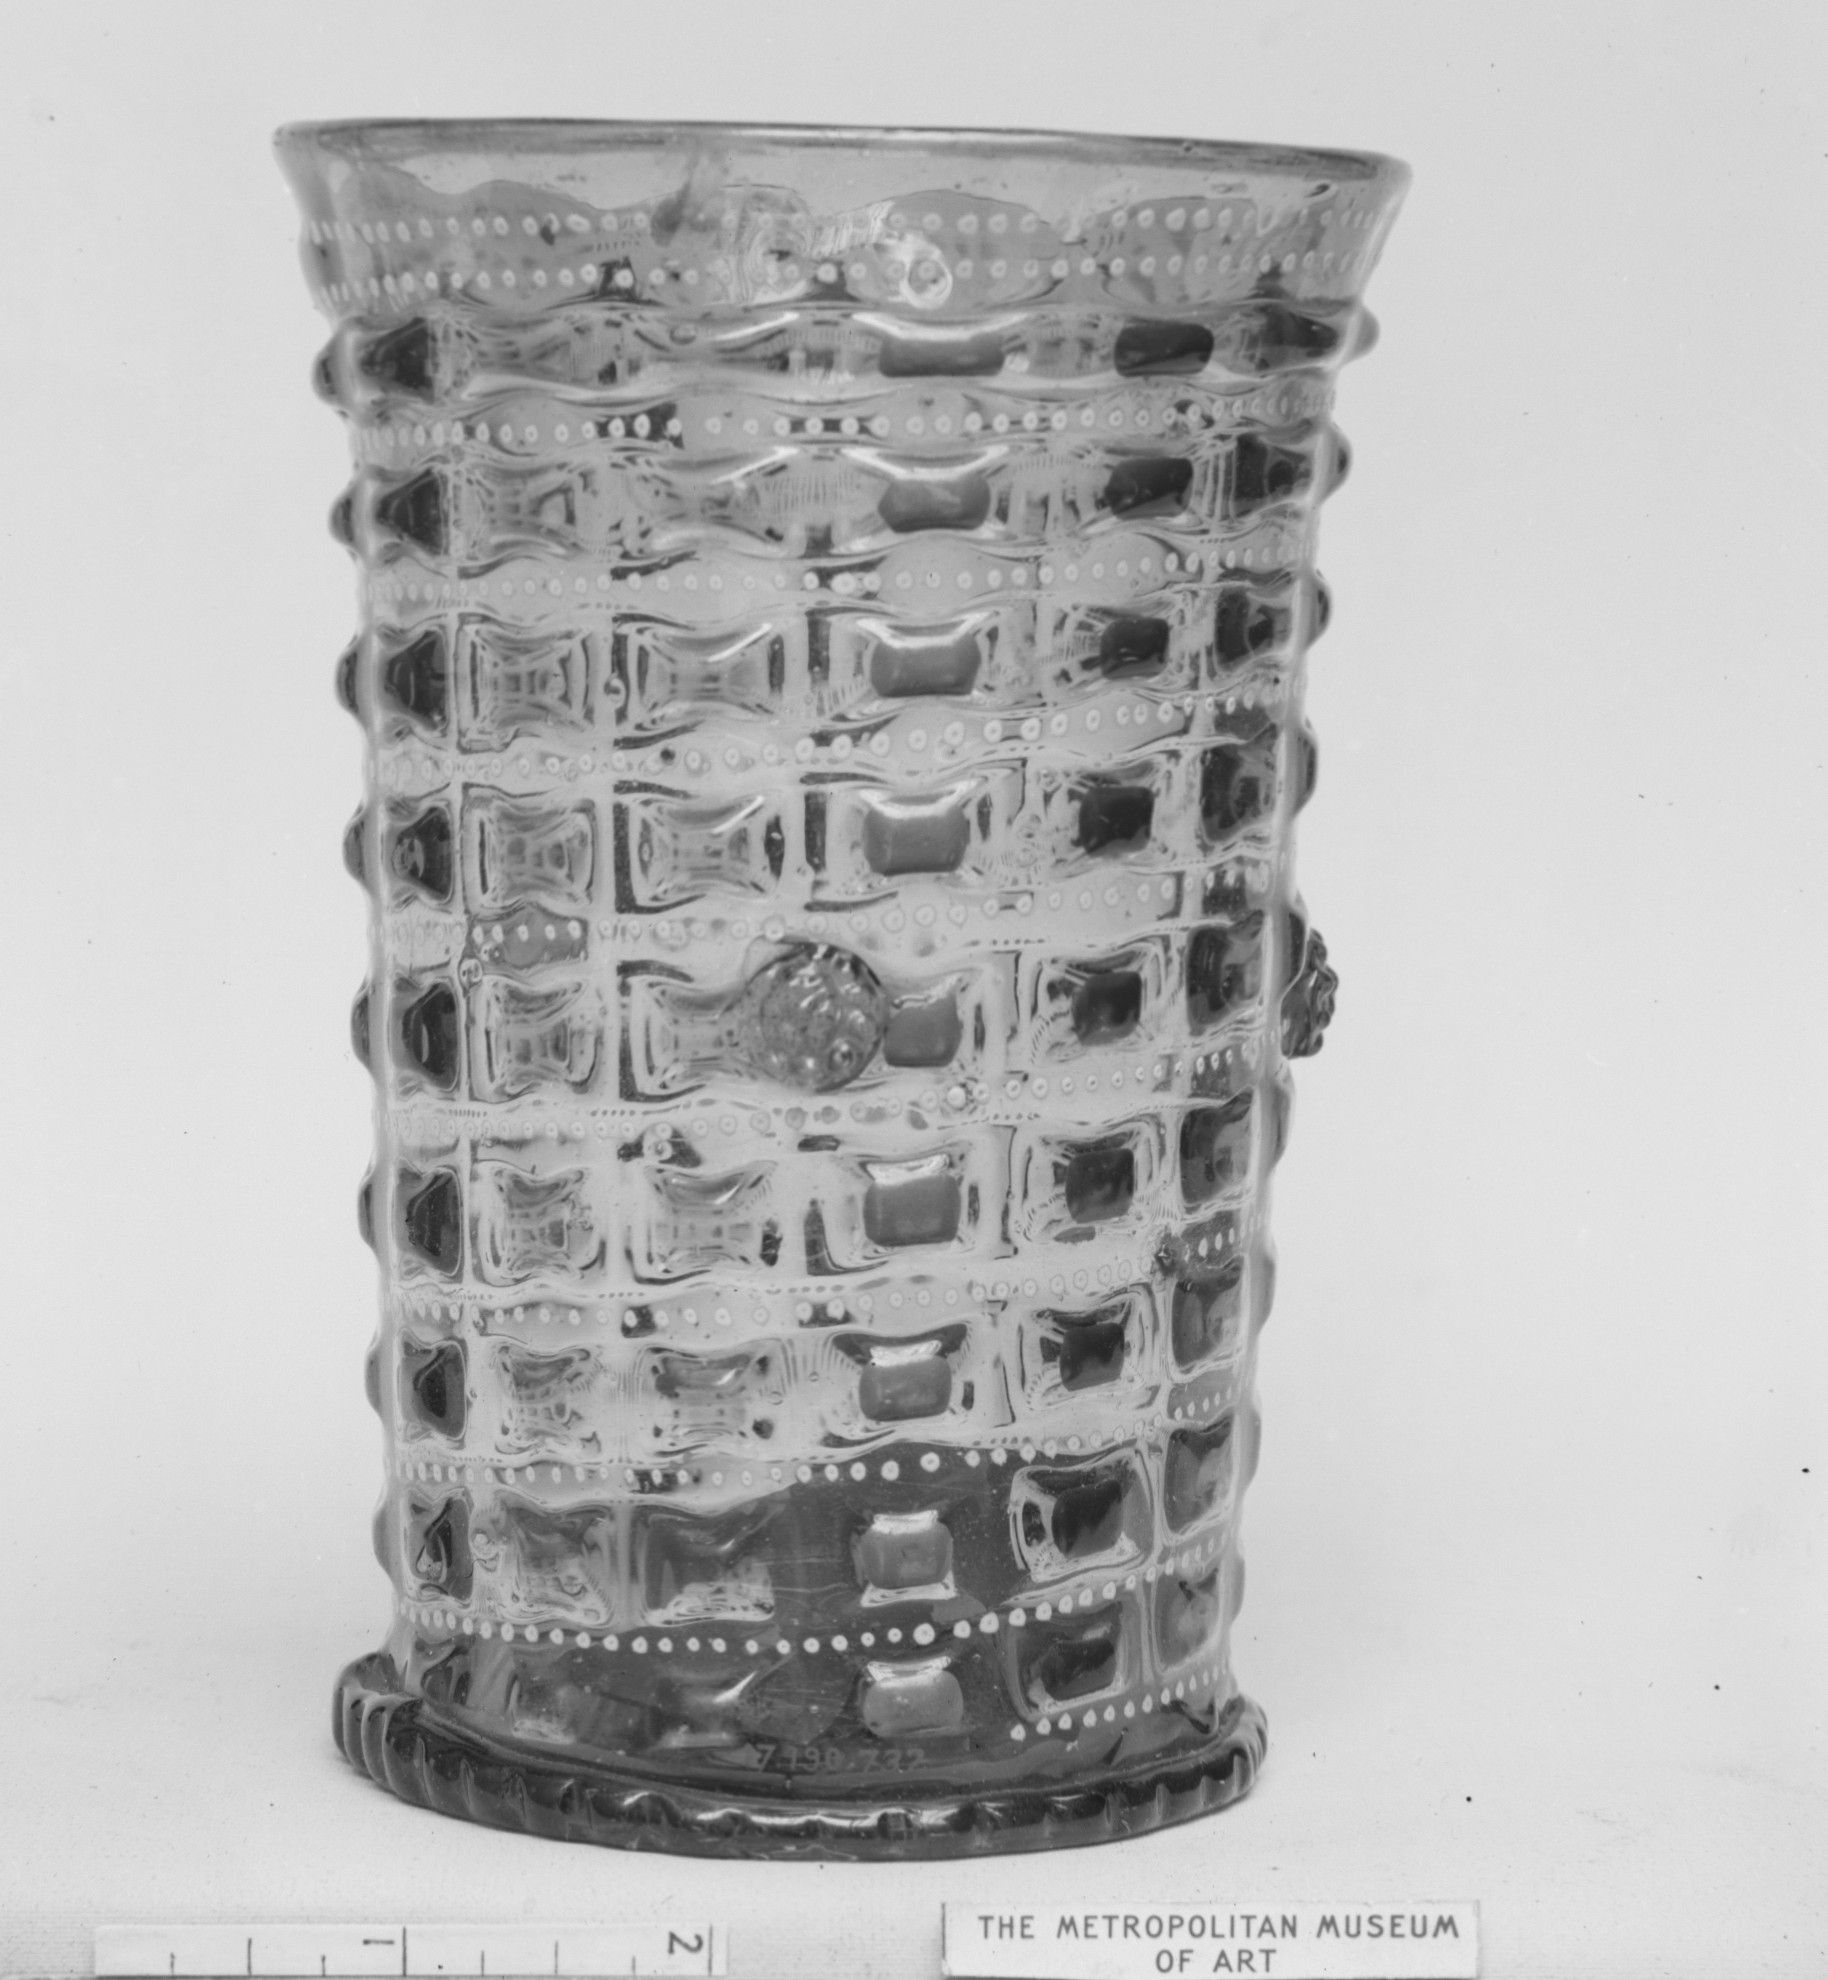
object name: beaker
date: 1567-1633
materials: glass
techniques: enamel